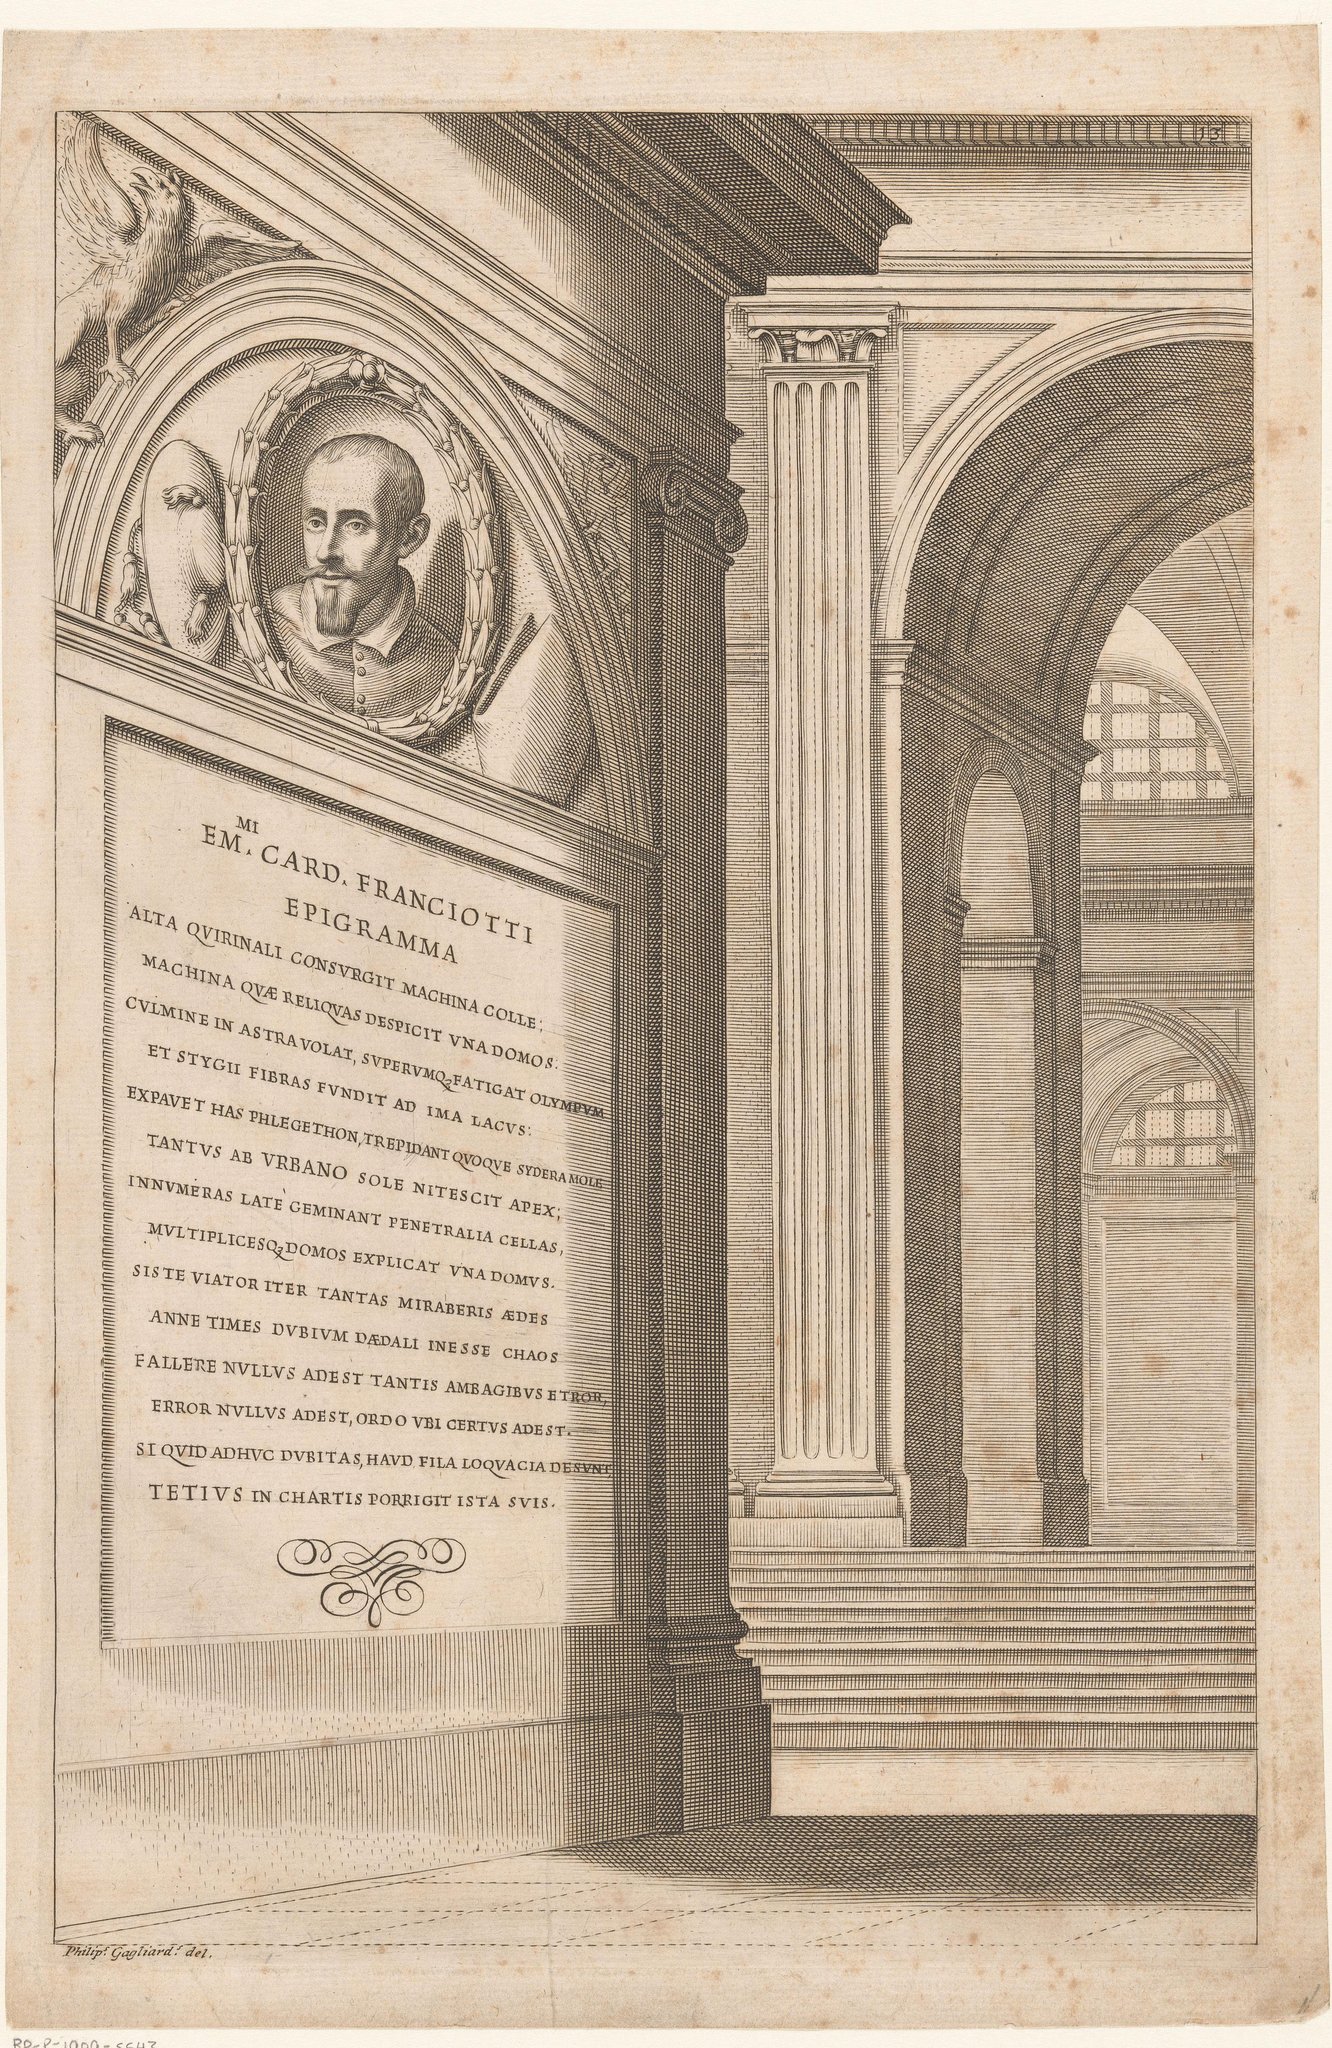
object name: book illustration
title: Monument voor kardinaal Marco Antonio Franciotti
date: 1642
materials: paper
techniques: engraving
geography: italy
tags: cardinal, historical persons, interior of church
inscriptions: collector's mark: Lugt 2228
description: Deze prent maakt deel uit van een reeks van 15 prenten met portretten van kardinalen onder paus Urbanus VIII, verwerkt in monumenten in kerkinterieurs. De reeks is gebruikt voor de publicatie: Teti, Girolamo. Aedes Barberinae. Rome: Mascardi, 1642. De publicatie bevat beschrijvingen van het Palazzo Barberini te Rome en illustraties door onder meer Johann Friedrich Greuter en Cornelis Bloemaert.